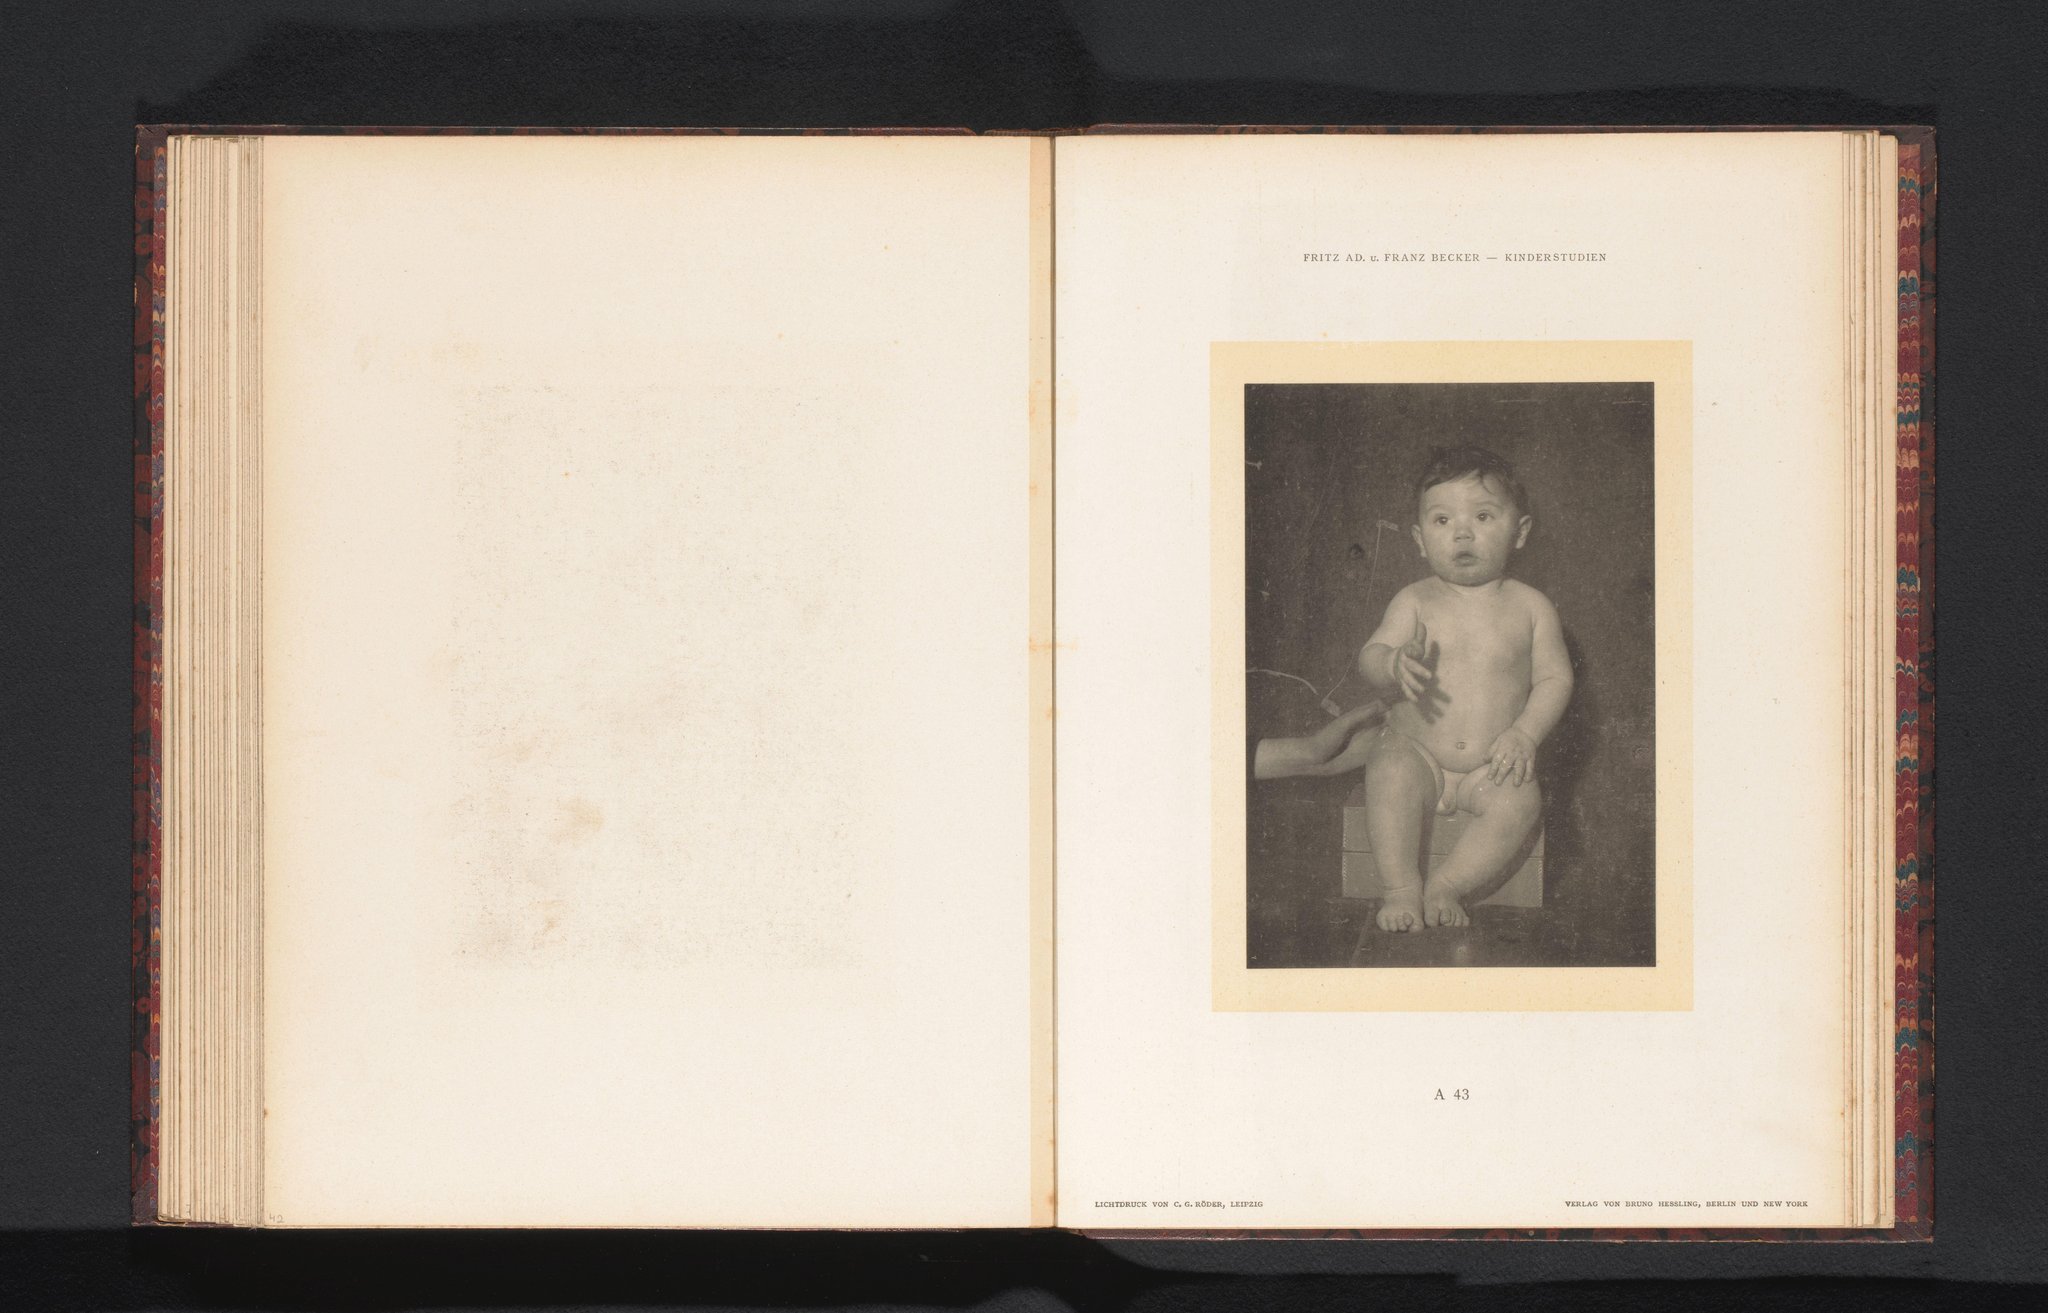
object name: page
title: Zittende naakte jongen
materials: paper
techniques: photograph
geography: leipzig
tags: toddler (male), sitting on an elevation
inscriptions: number: ‘A 43’